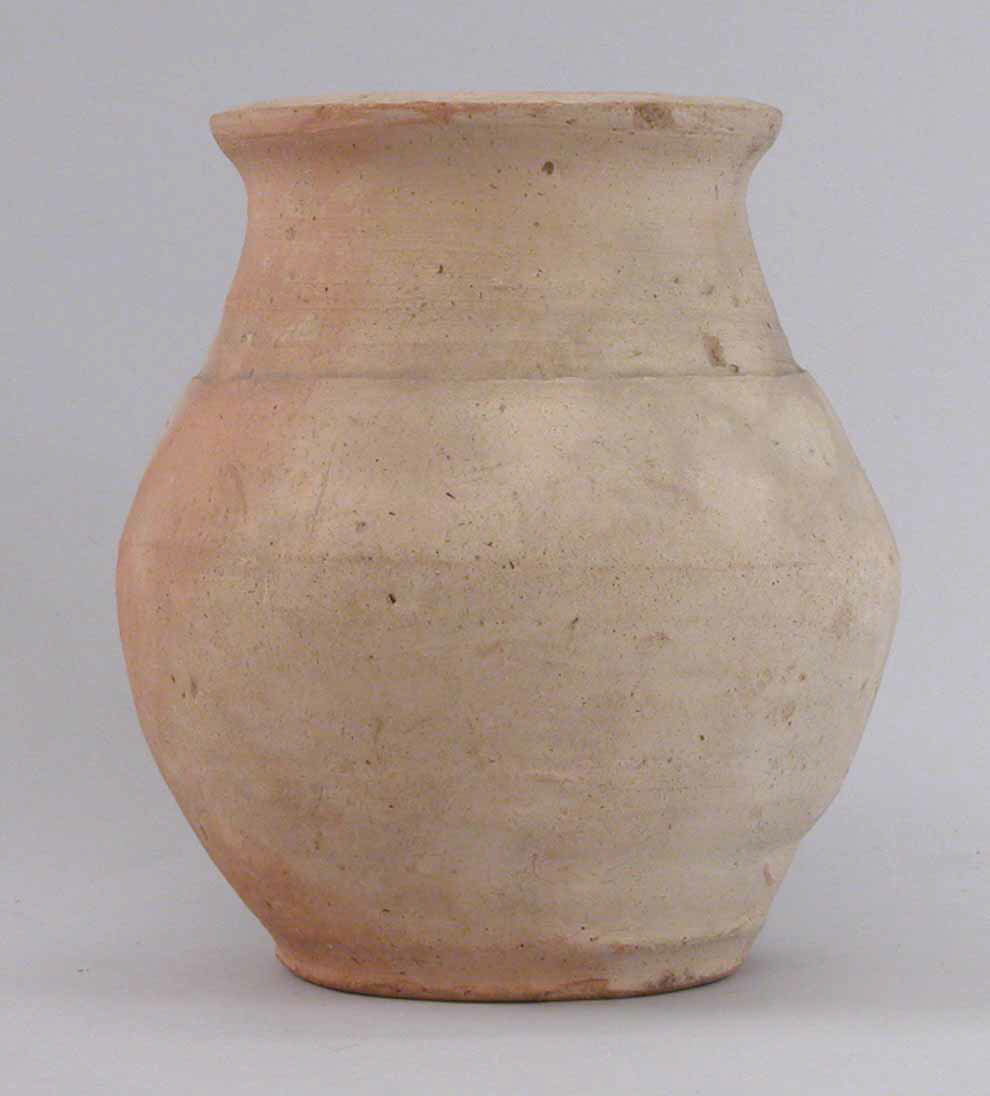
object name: jar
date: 801-900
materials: earthenware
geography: iran